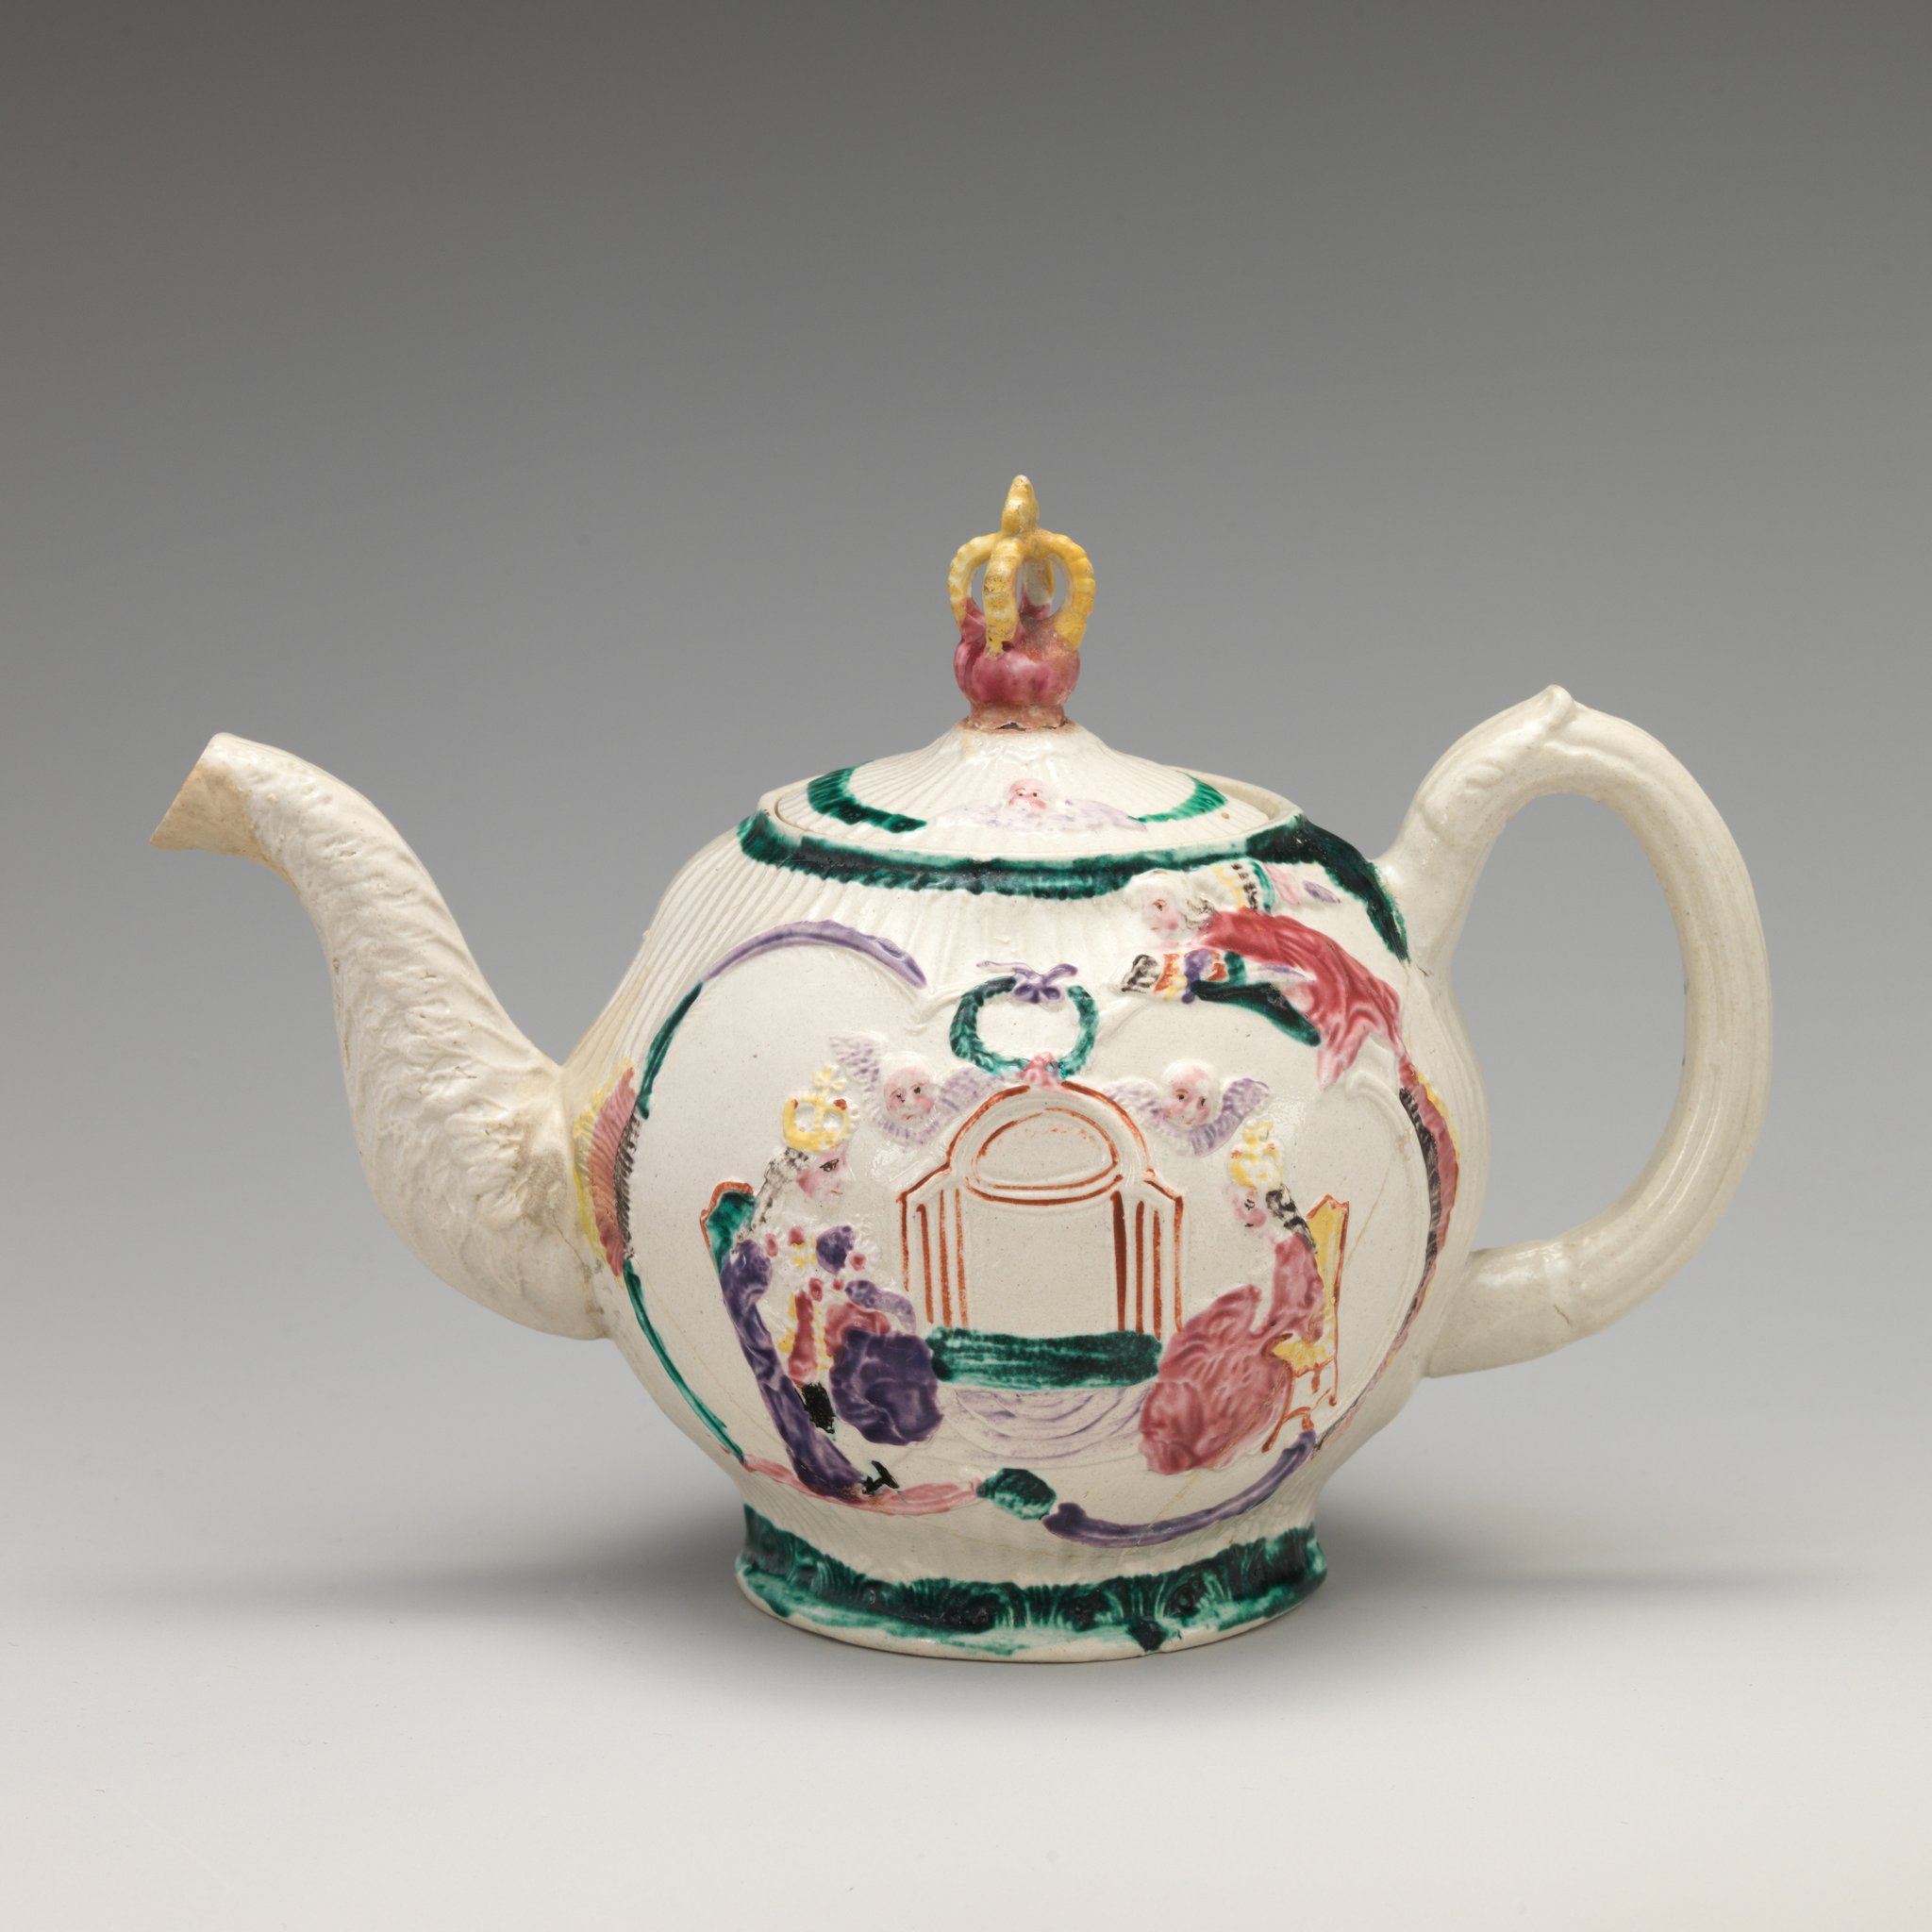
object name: teapot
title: Coronation teapot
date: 1761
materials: stoneware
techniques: salt glaze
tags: human figures